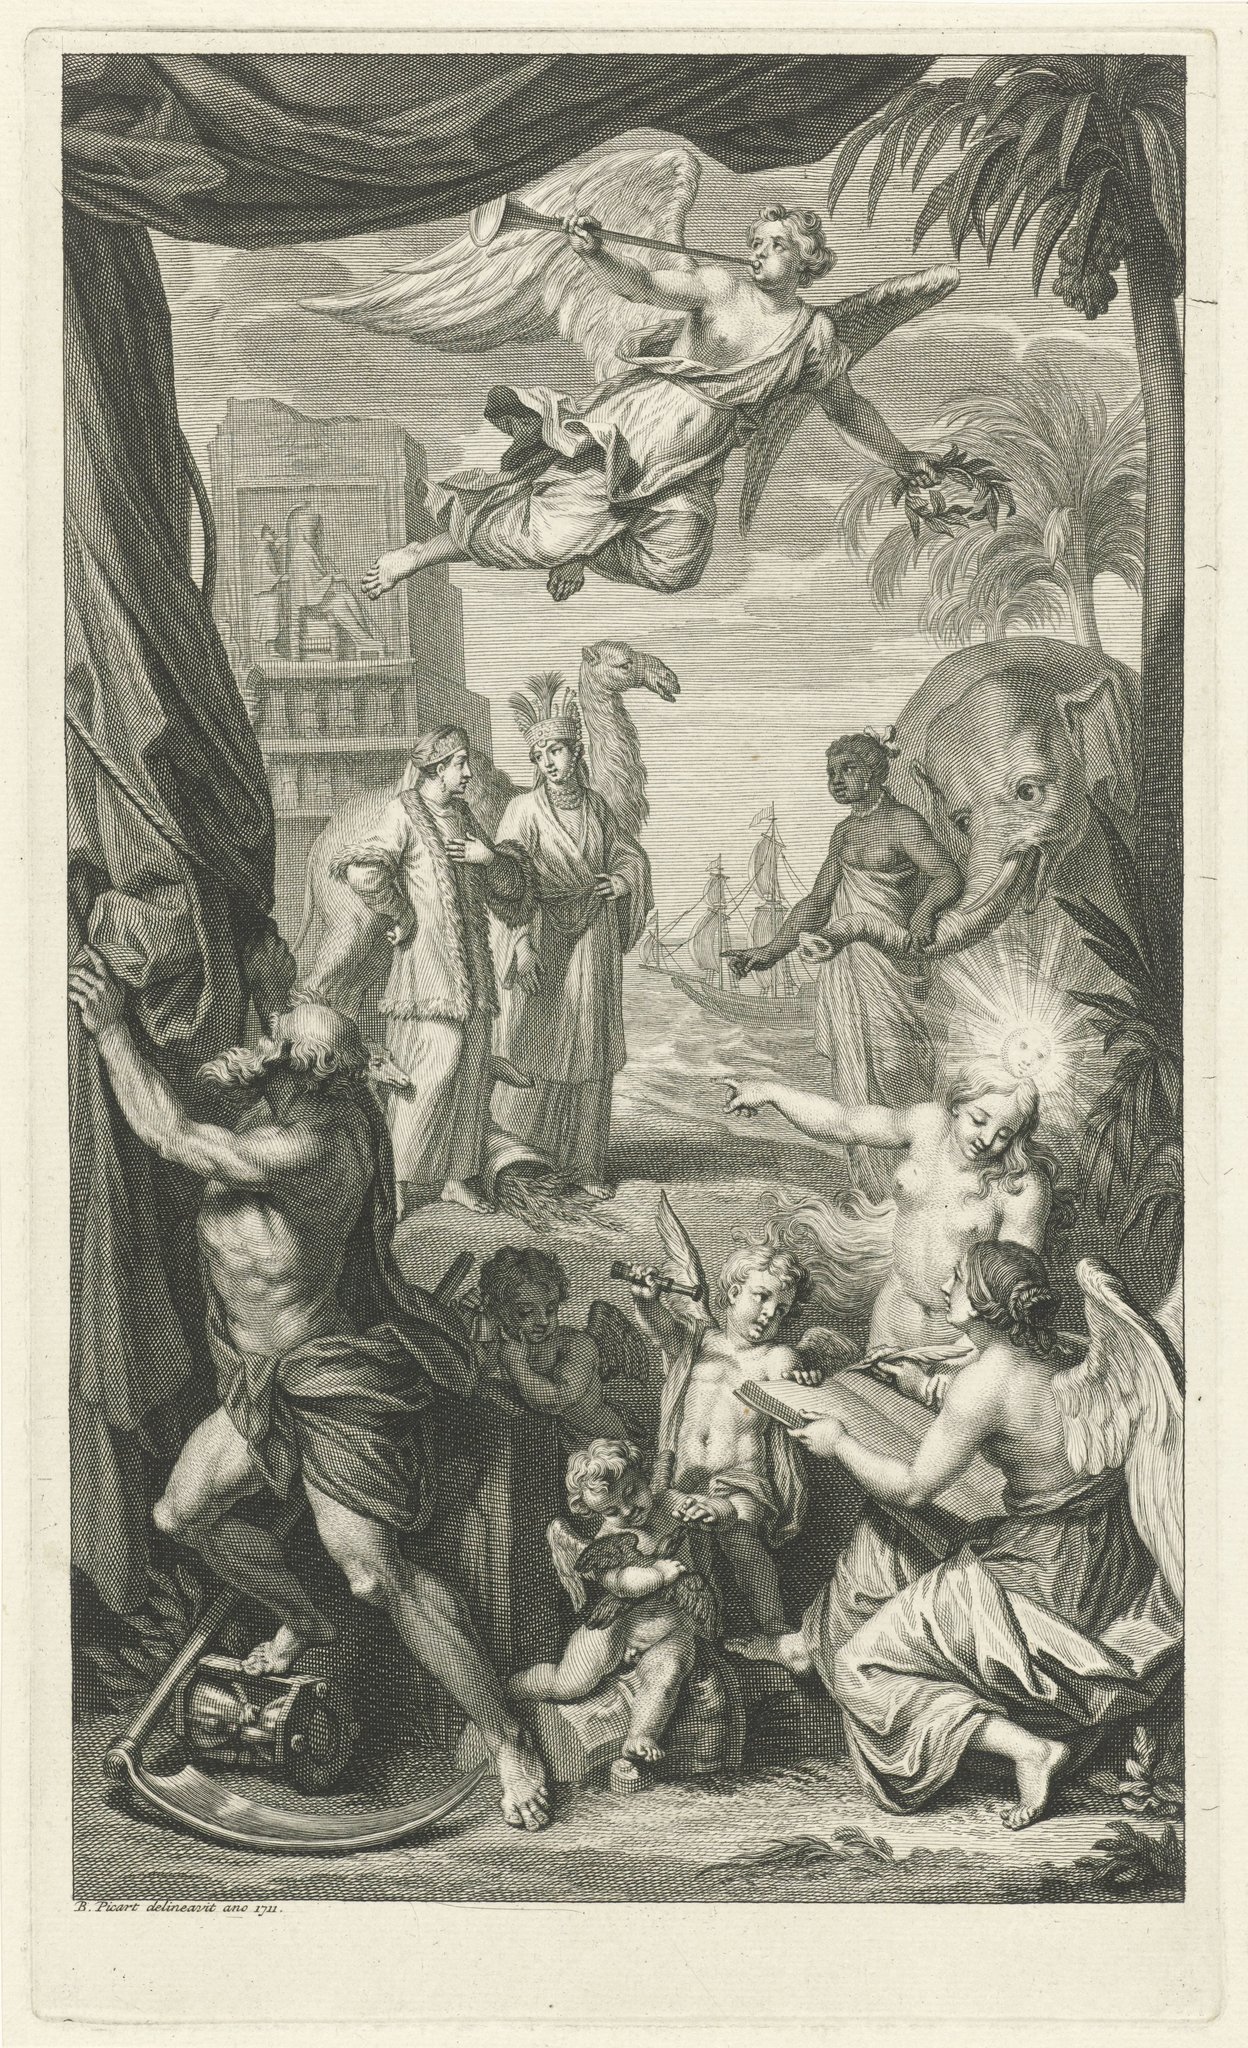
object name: titelblad, titelpagina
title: Allegorische titelpagina door Vader Tijd onthuld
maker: bernard picart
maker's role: draughtsman, print maker, publisher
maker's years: 1673-1733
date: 1711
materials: paper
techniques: engraving, etching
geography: amsterdam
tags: hoofed animals: dromedary, africans, 'historia'; 'historia' (ripa), fame; 'fama', 'fama buona', 'fama chiara' (ripa), asiatic races and peoples: persians, father time, man with wings and scythe, trunked animals: elephant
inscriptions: collector's mark: Lugt 2228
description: Vader Tijd schuift een draperie opzij en onthult het tafereel. Geschiedenis schrijft in een boek. Ze wordt vergezeld door putti met verschillende attributen in de handen. De gepersonifieerde Waarheid, een stralende zon boven het hoofd, wijst haar op de achtergrond. Daar wandelen twee exotisch uitgedoste personen (Perzen?) met een dromedaris en een zwarte vrouw met een olifant. In de lucht vliegt Faam die de bazuin blaast, met een lauwerkrans in de hand.